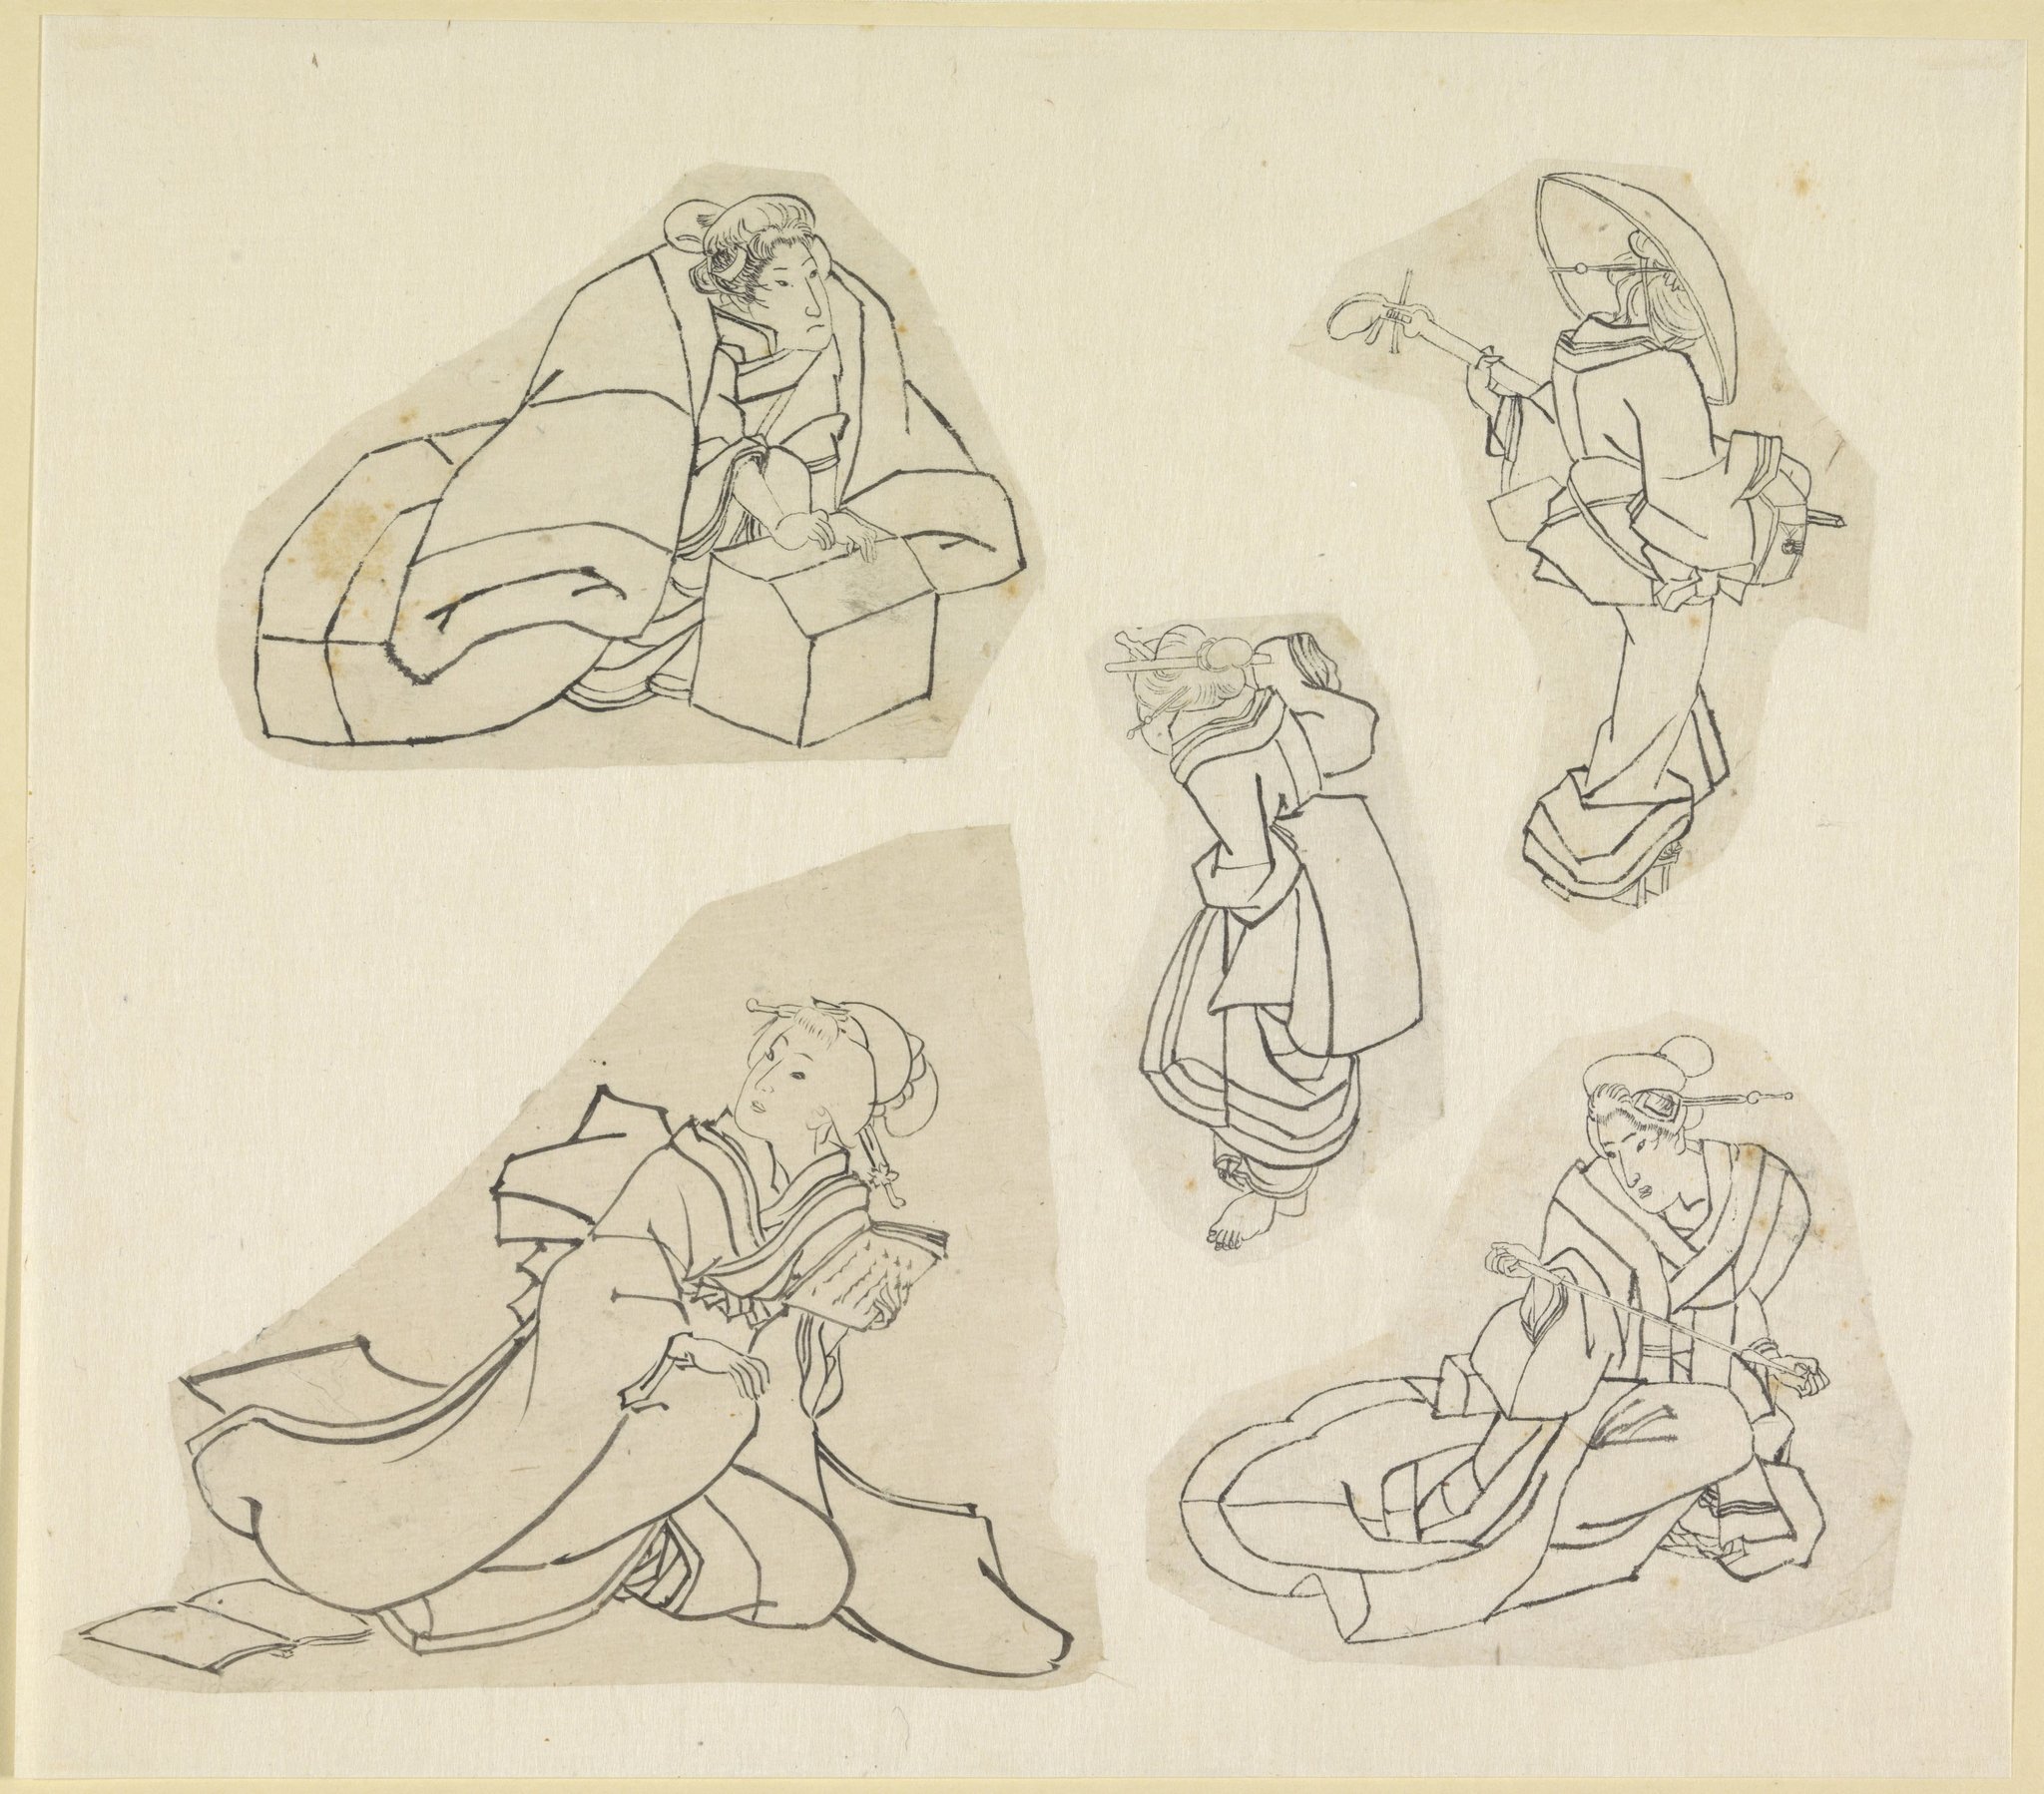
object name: drawing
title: Vijf vrouwenfiguren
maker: katsushika hokusai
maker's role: draughtsman, print maker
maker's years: 1760-1849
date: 1800-1900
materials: paper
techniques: brush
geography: japan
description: Blad met vijf opgeplakte tekeningen van vrouwenfiguren, waarvan een met een pijp, een lezende en een met een shamisen.